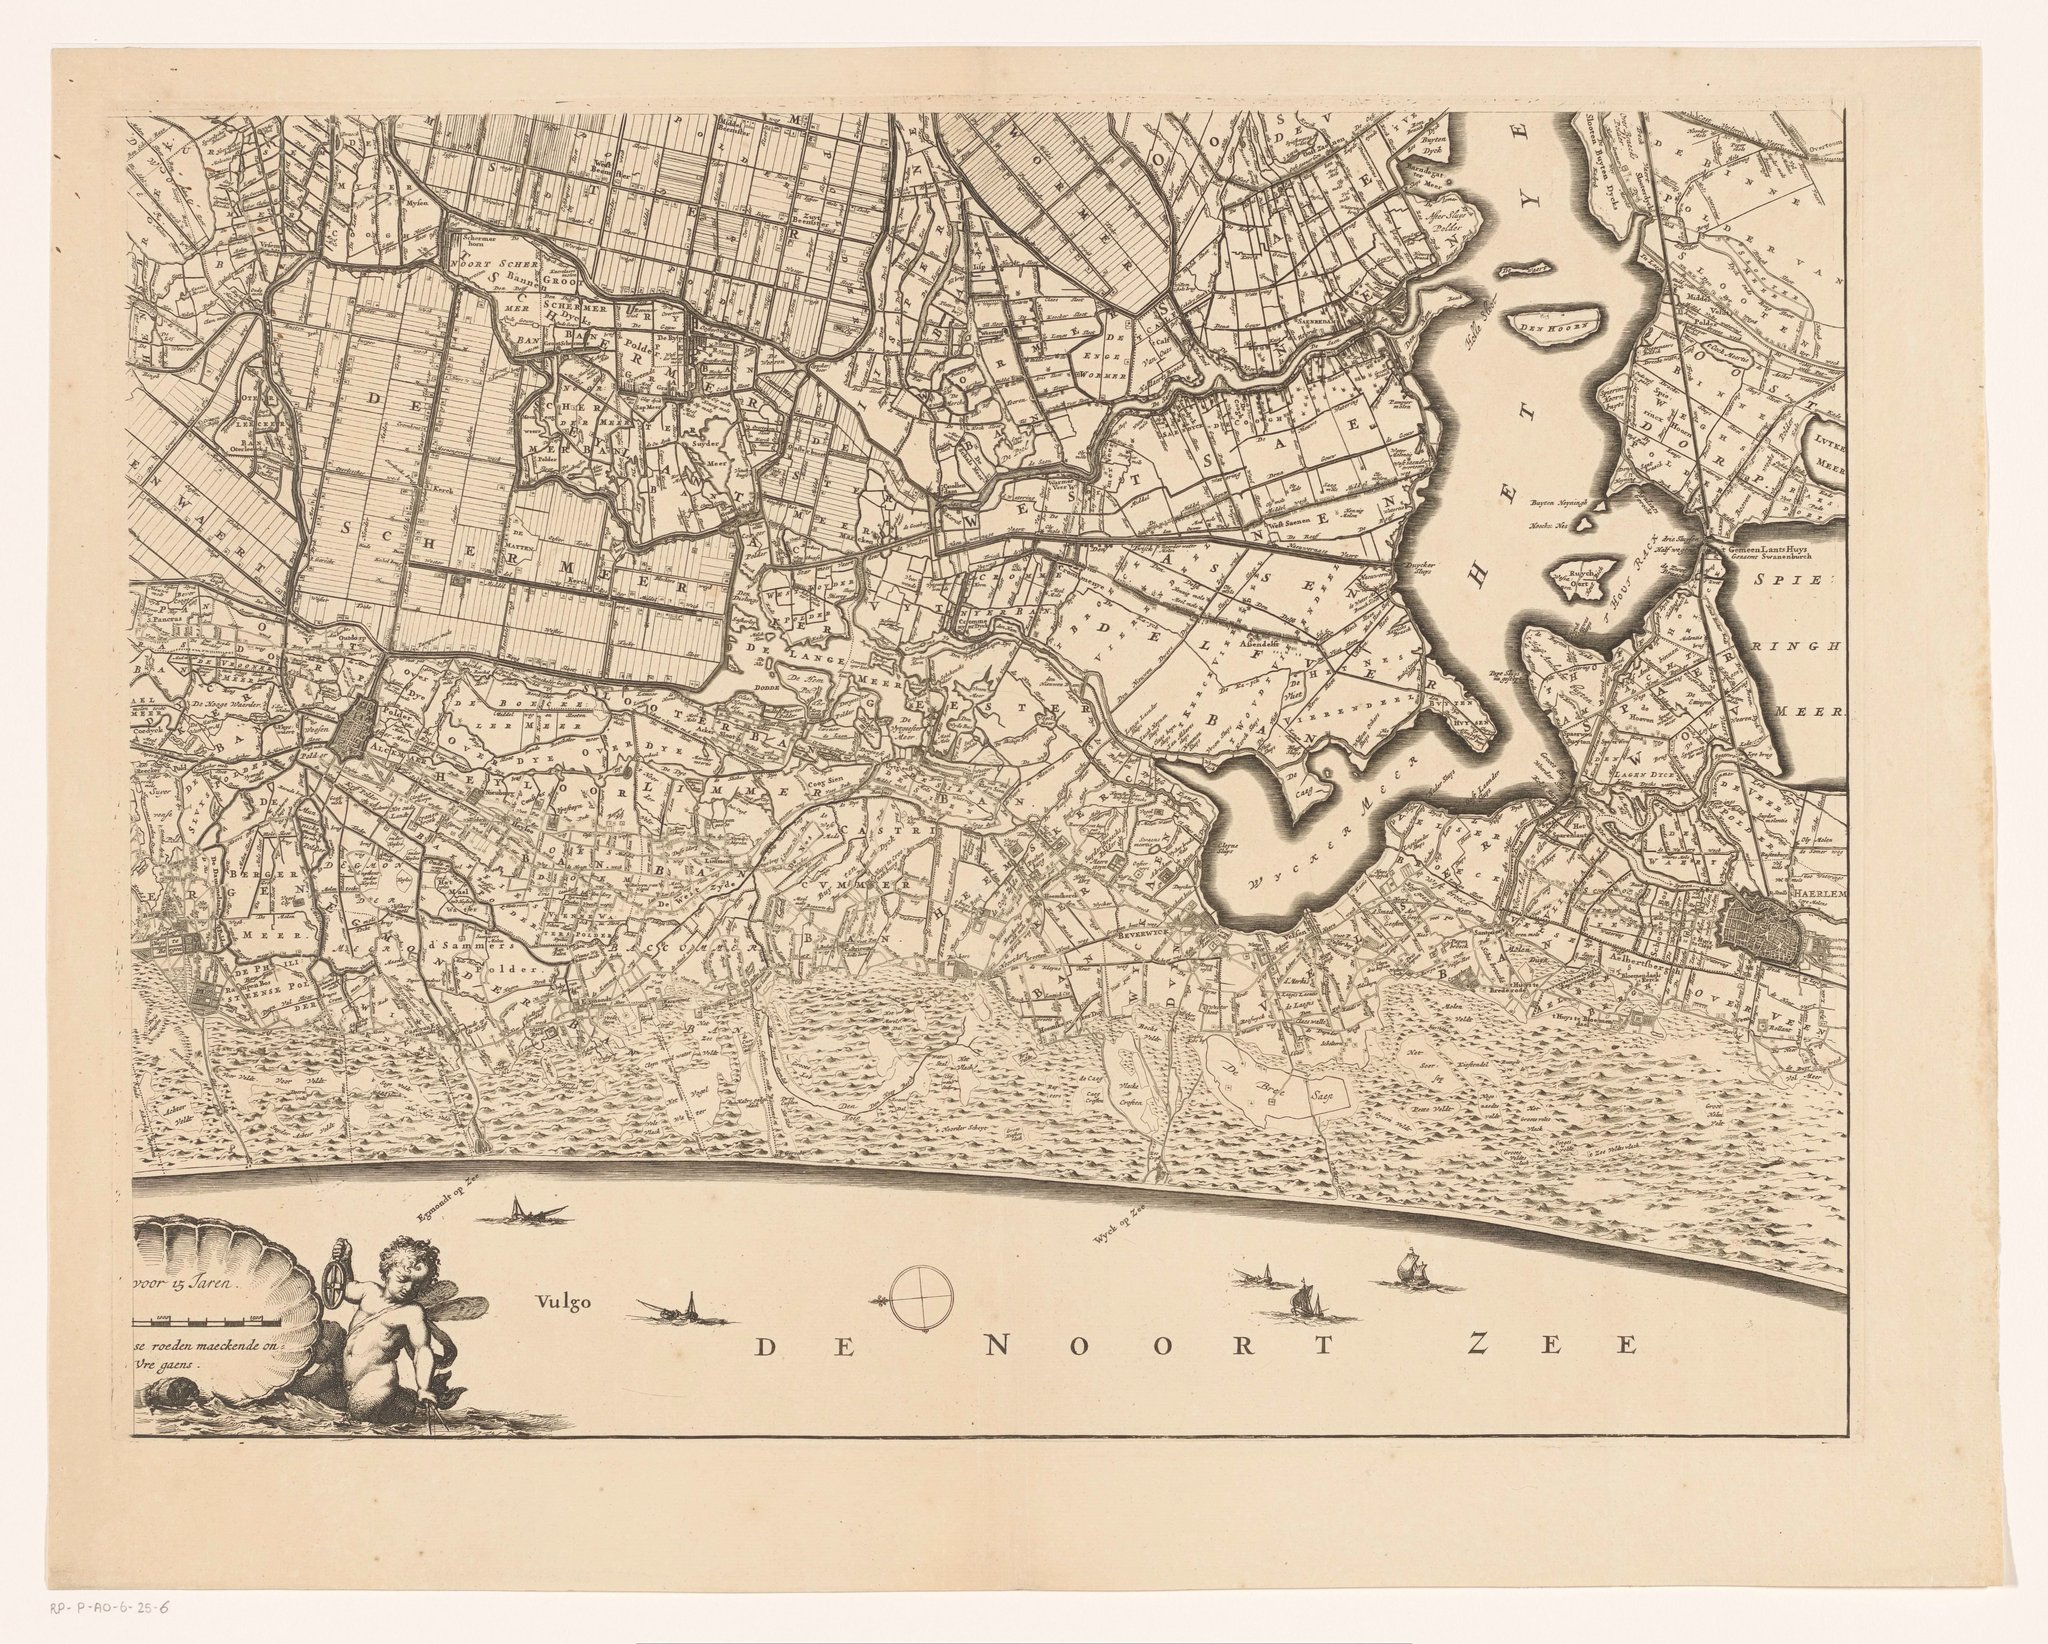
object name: print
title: 't Hoogh-heemraetschap vande Uytwaterende Sluysen in Kennemerlant ende West-Frieslant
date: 1682-1811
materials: paper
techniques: engraving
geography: amsterdam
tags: maps of separate countries or regions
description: In de collectie van het Rijksprentenkabinet bevinden zich verschillende exemplaren en staten van de vierdelige kaart waar dit blad (deel rechtsonder op de kaart) onderdeel van is. De kaarten zijn te dateren aan de hand van de namen van de dijkgraaf, hoogheemraden en rentmeester, te vinden op de twee bovenste bladen van de kaart. Omdat de twee onderste bladen door de jaren heen onveranderd zijn gebleven en niet duidelijk is welke losse onderste bladen bij welke bovenste horen, kunnen de onderste bladen niet precies gedateerd worden. Van het huidige blad zijn vier exemplaren te vinden in de collectie. Gesteld kan worden dat drie hiervan óf bij de vierde staat uit 1734-1739, óf bij de vijfde staat uit 1745 horen. Maar gezien niet duidelijk is welk blad waar bij hoort en er een extra blad is dat tussen 1682 en 1811 gedateerd moet worden, zijn alle rechtsonder-bladen gedateerd op 1682-1811.